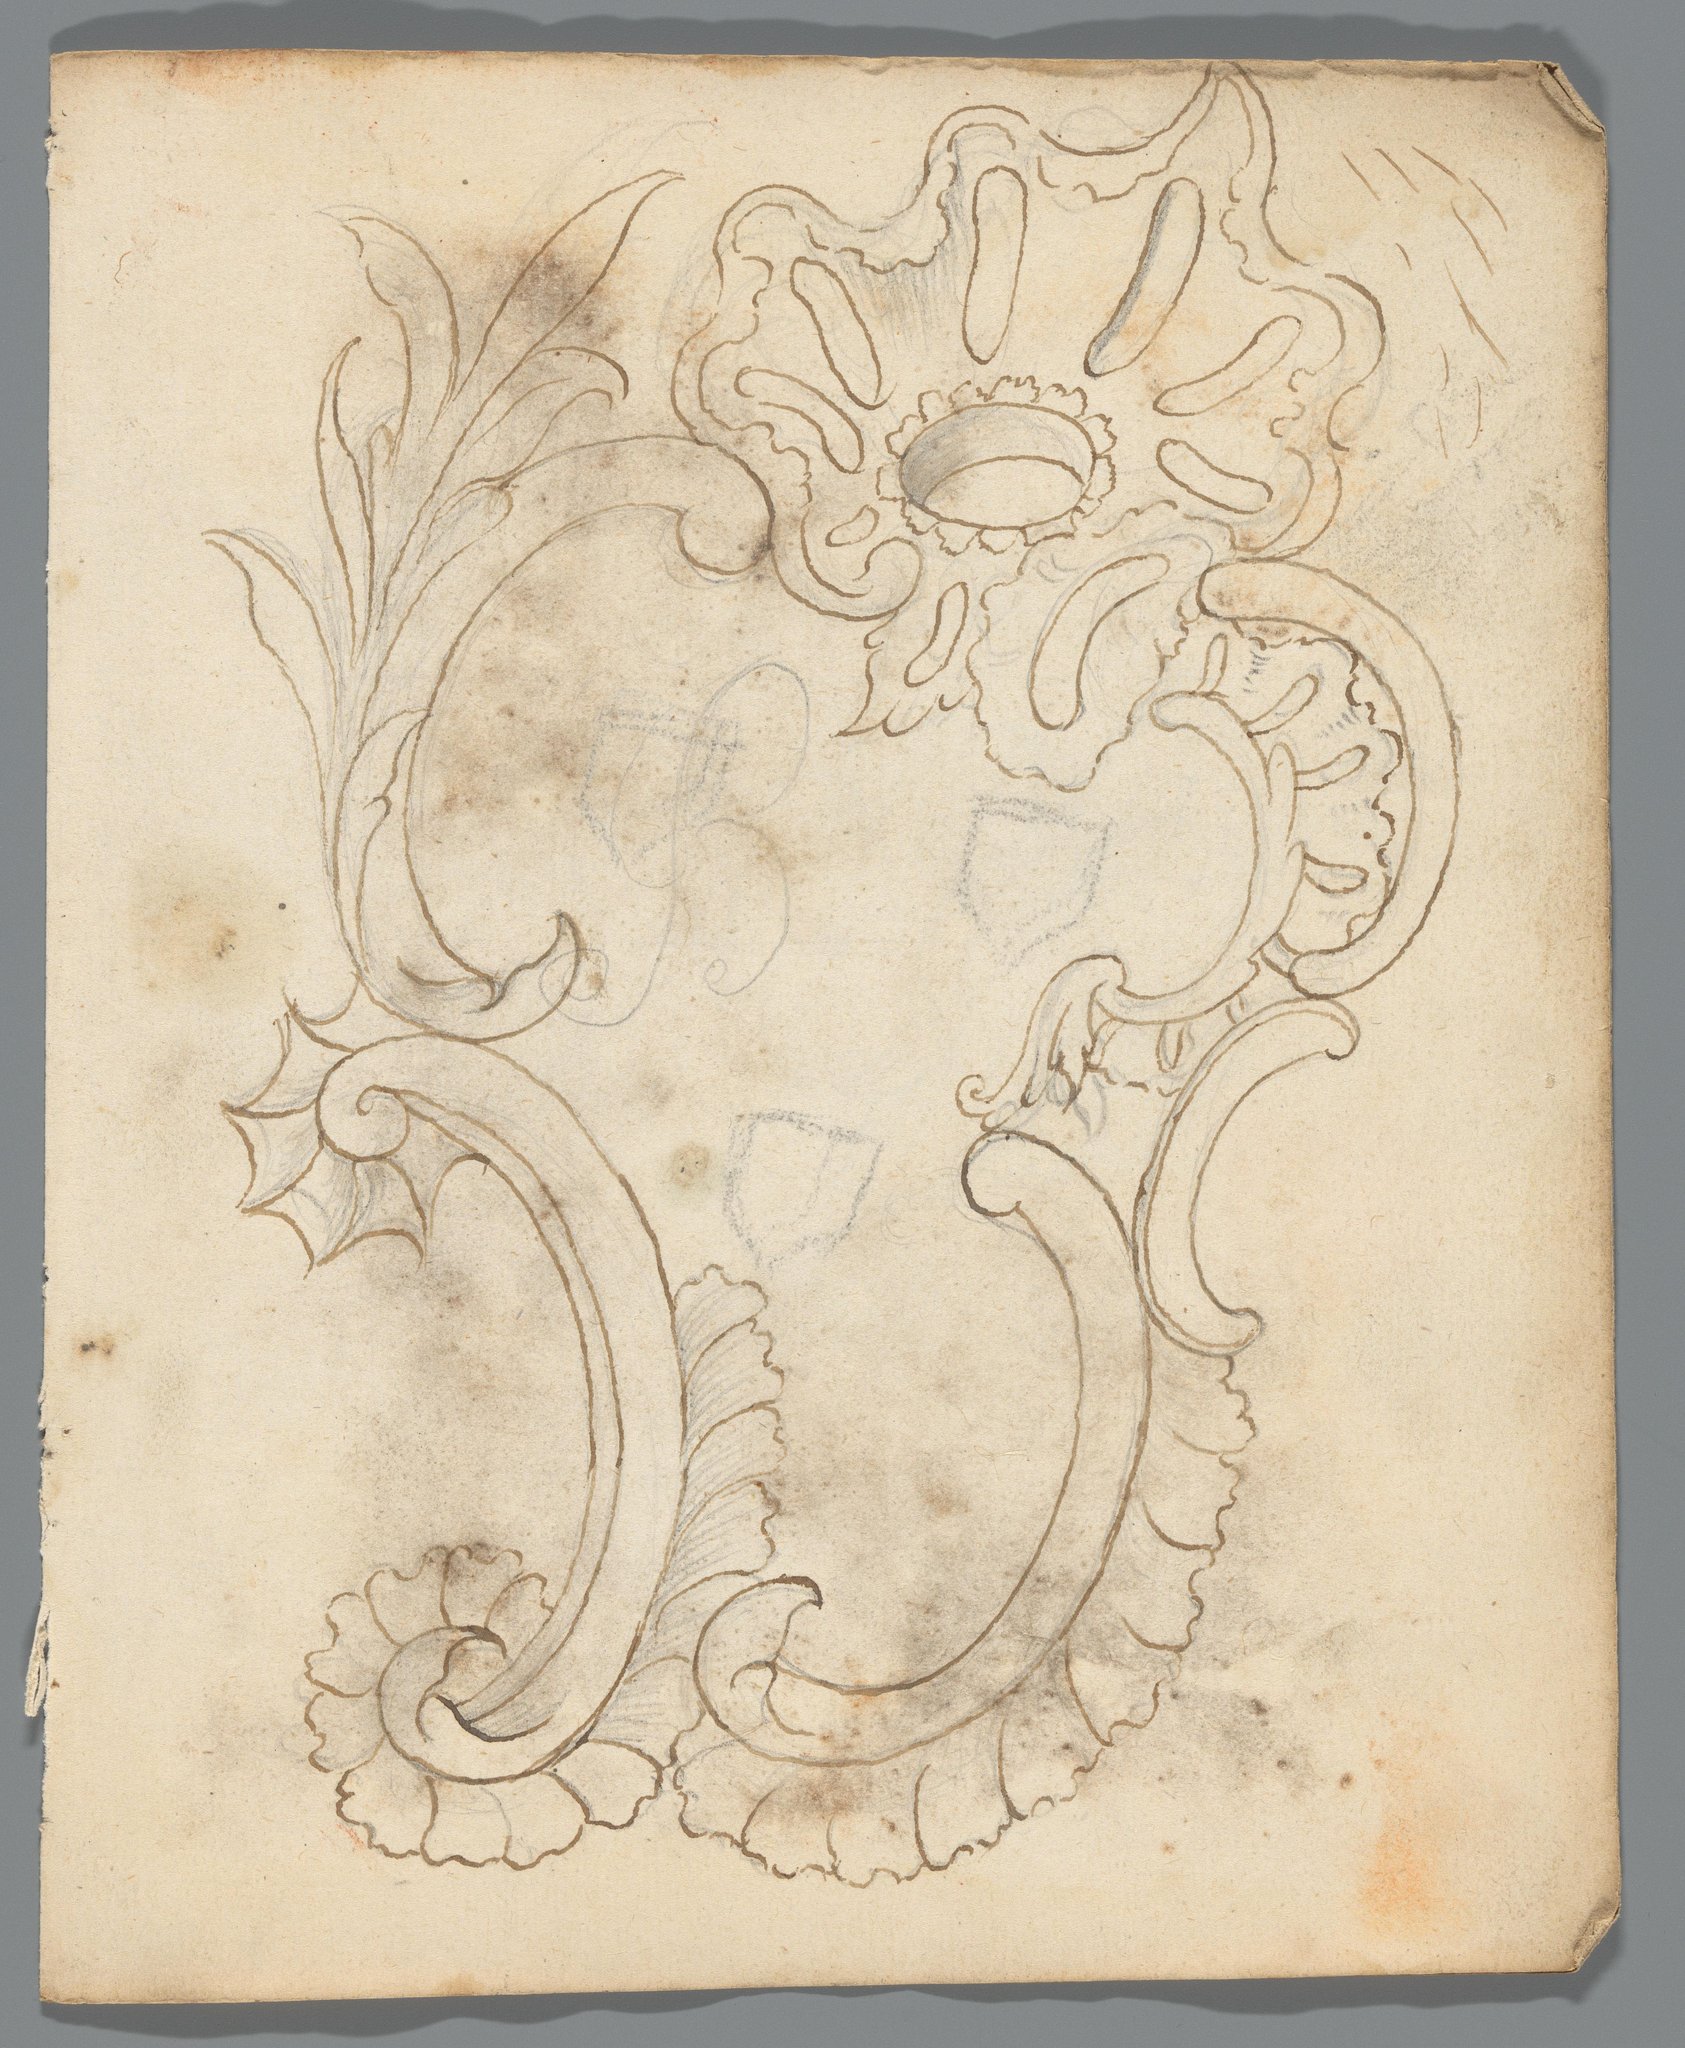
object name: drawing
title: Ontwerp voor een cartouche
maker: Anonymous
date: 1750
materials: ink, paper, pencil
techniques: pen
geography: netherlands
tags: scallop, shell ~ ornament - aa - stylized, ornament ~ cartouche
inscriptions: watermark, watermark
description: Ontwerp voor een cartouche in rococostijl. Onderdeel van het album (gedeeltelijk losbladig) met zestien ontwerpen voor cartouches.